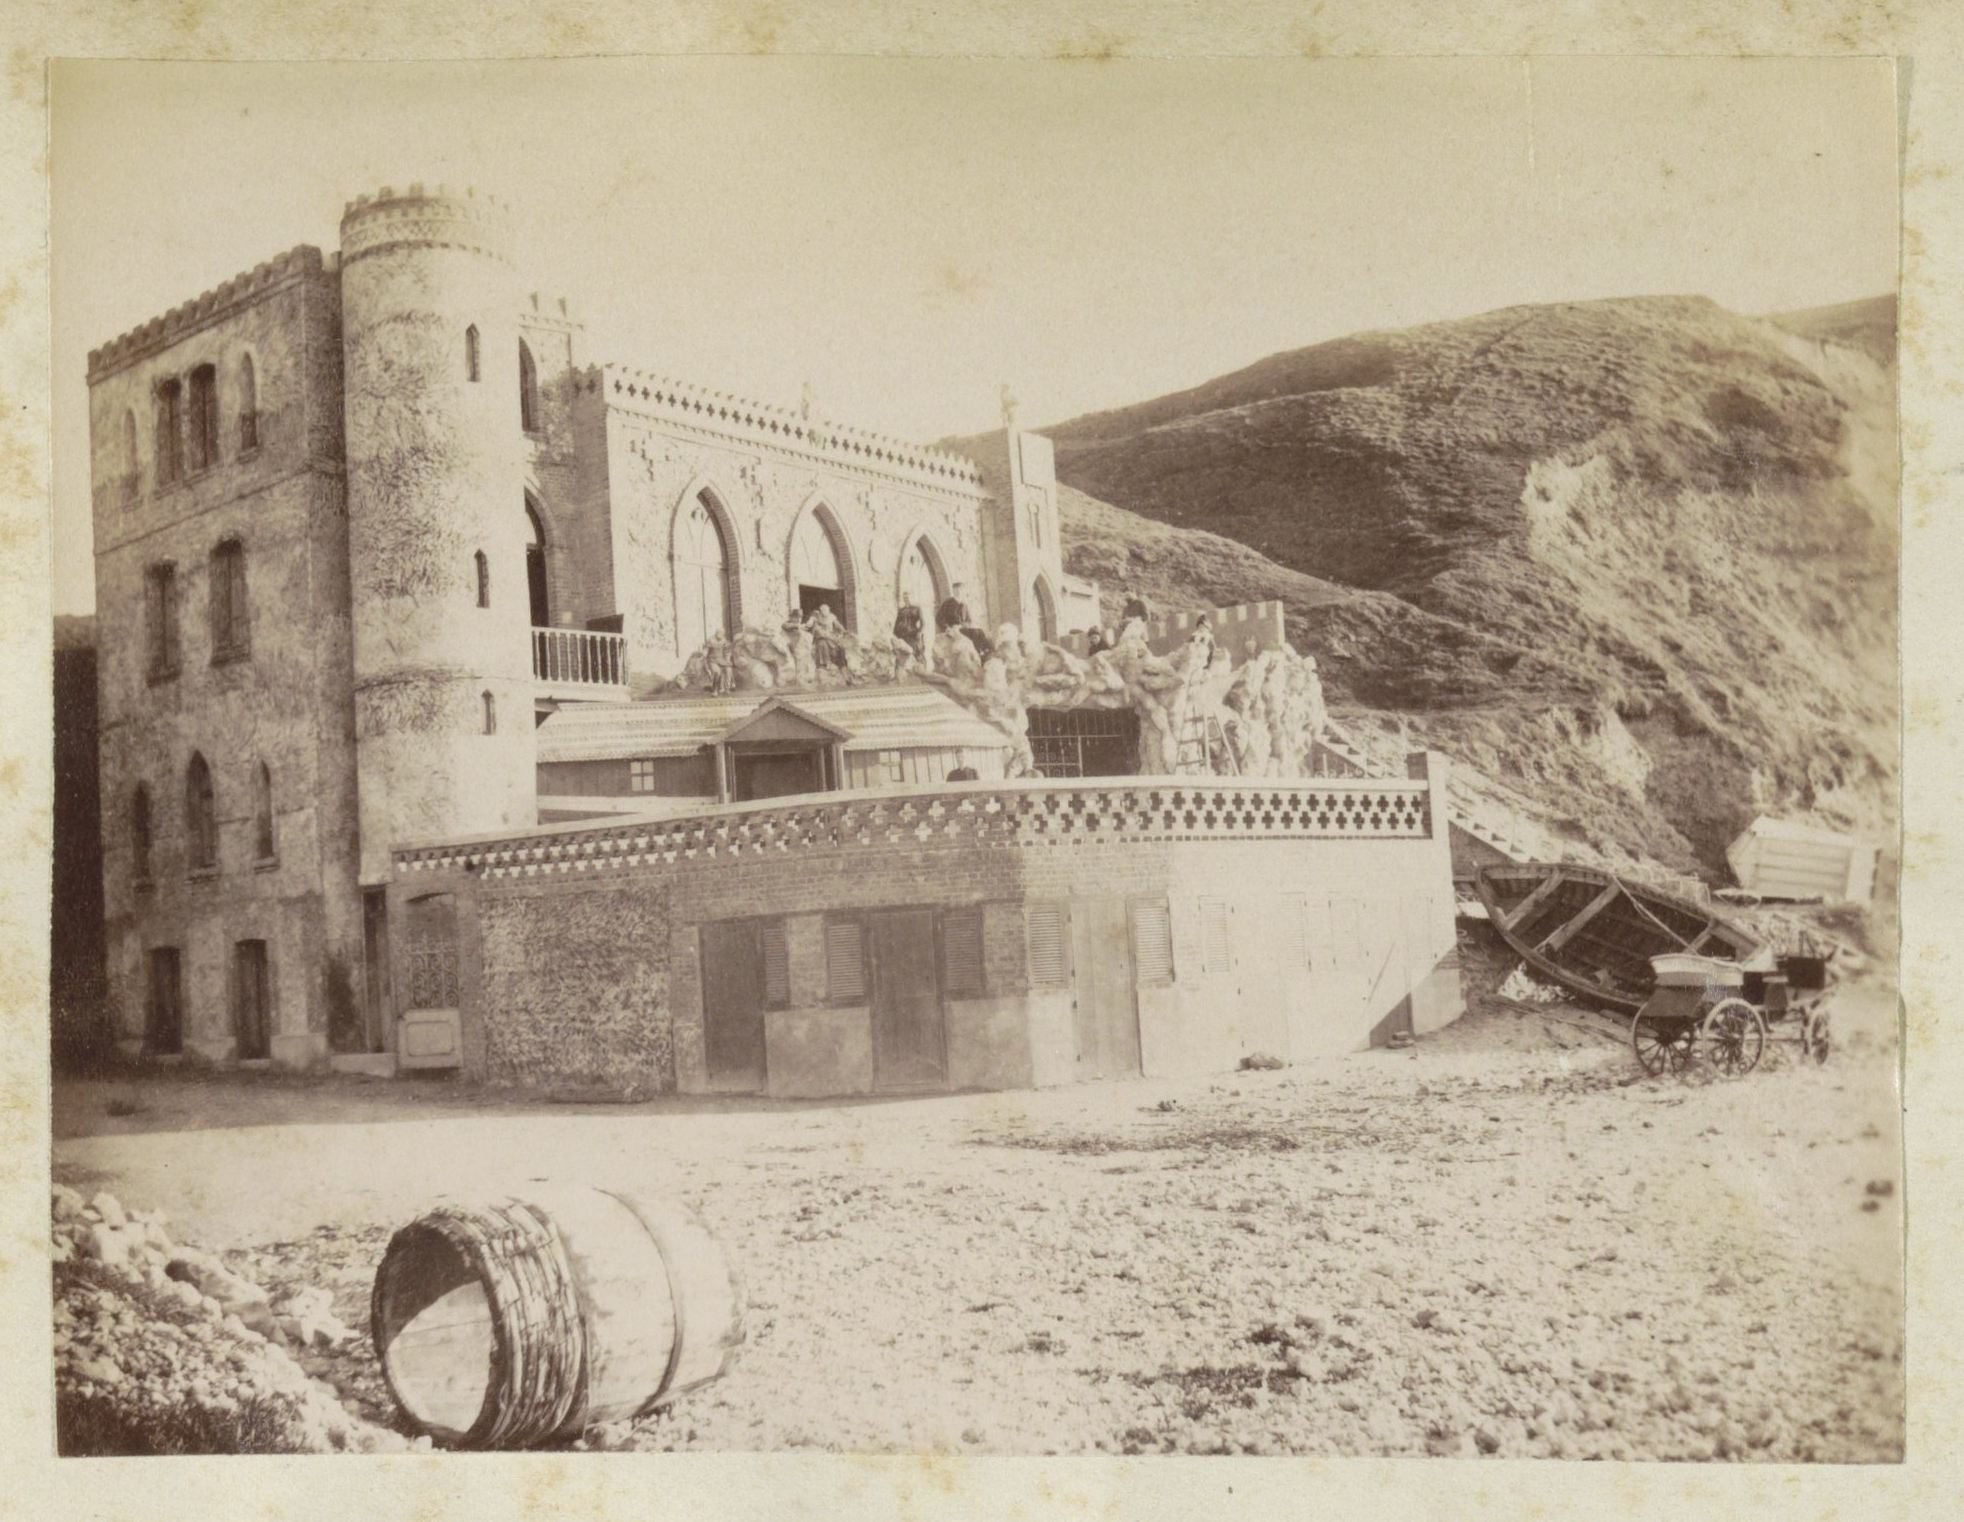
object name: photograph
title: Exterieur van een villa in Saint-Jouin-Bruneval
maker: Anonymous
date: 1809-1885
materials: photographic support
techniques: albumen print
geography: saint-jouin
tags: castle, villa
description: Onderdeel van Album van een Franse amateurfotograaf met opnames van familie, militairen, industrie, landschappen en bezienswaardigheden in Frankrijk.